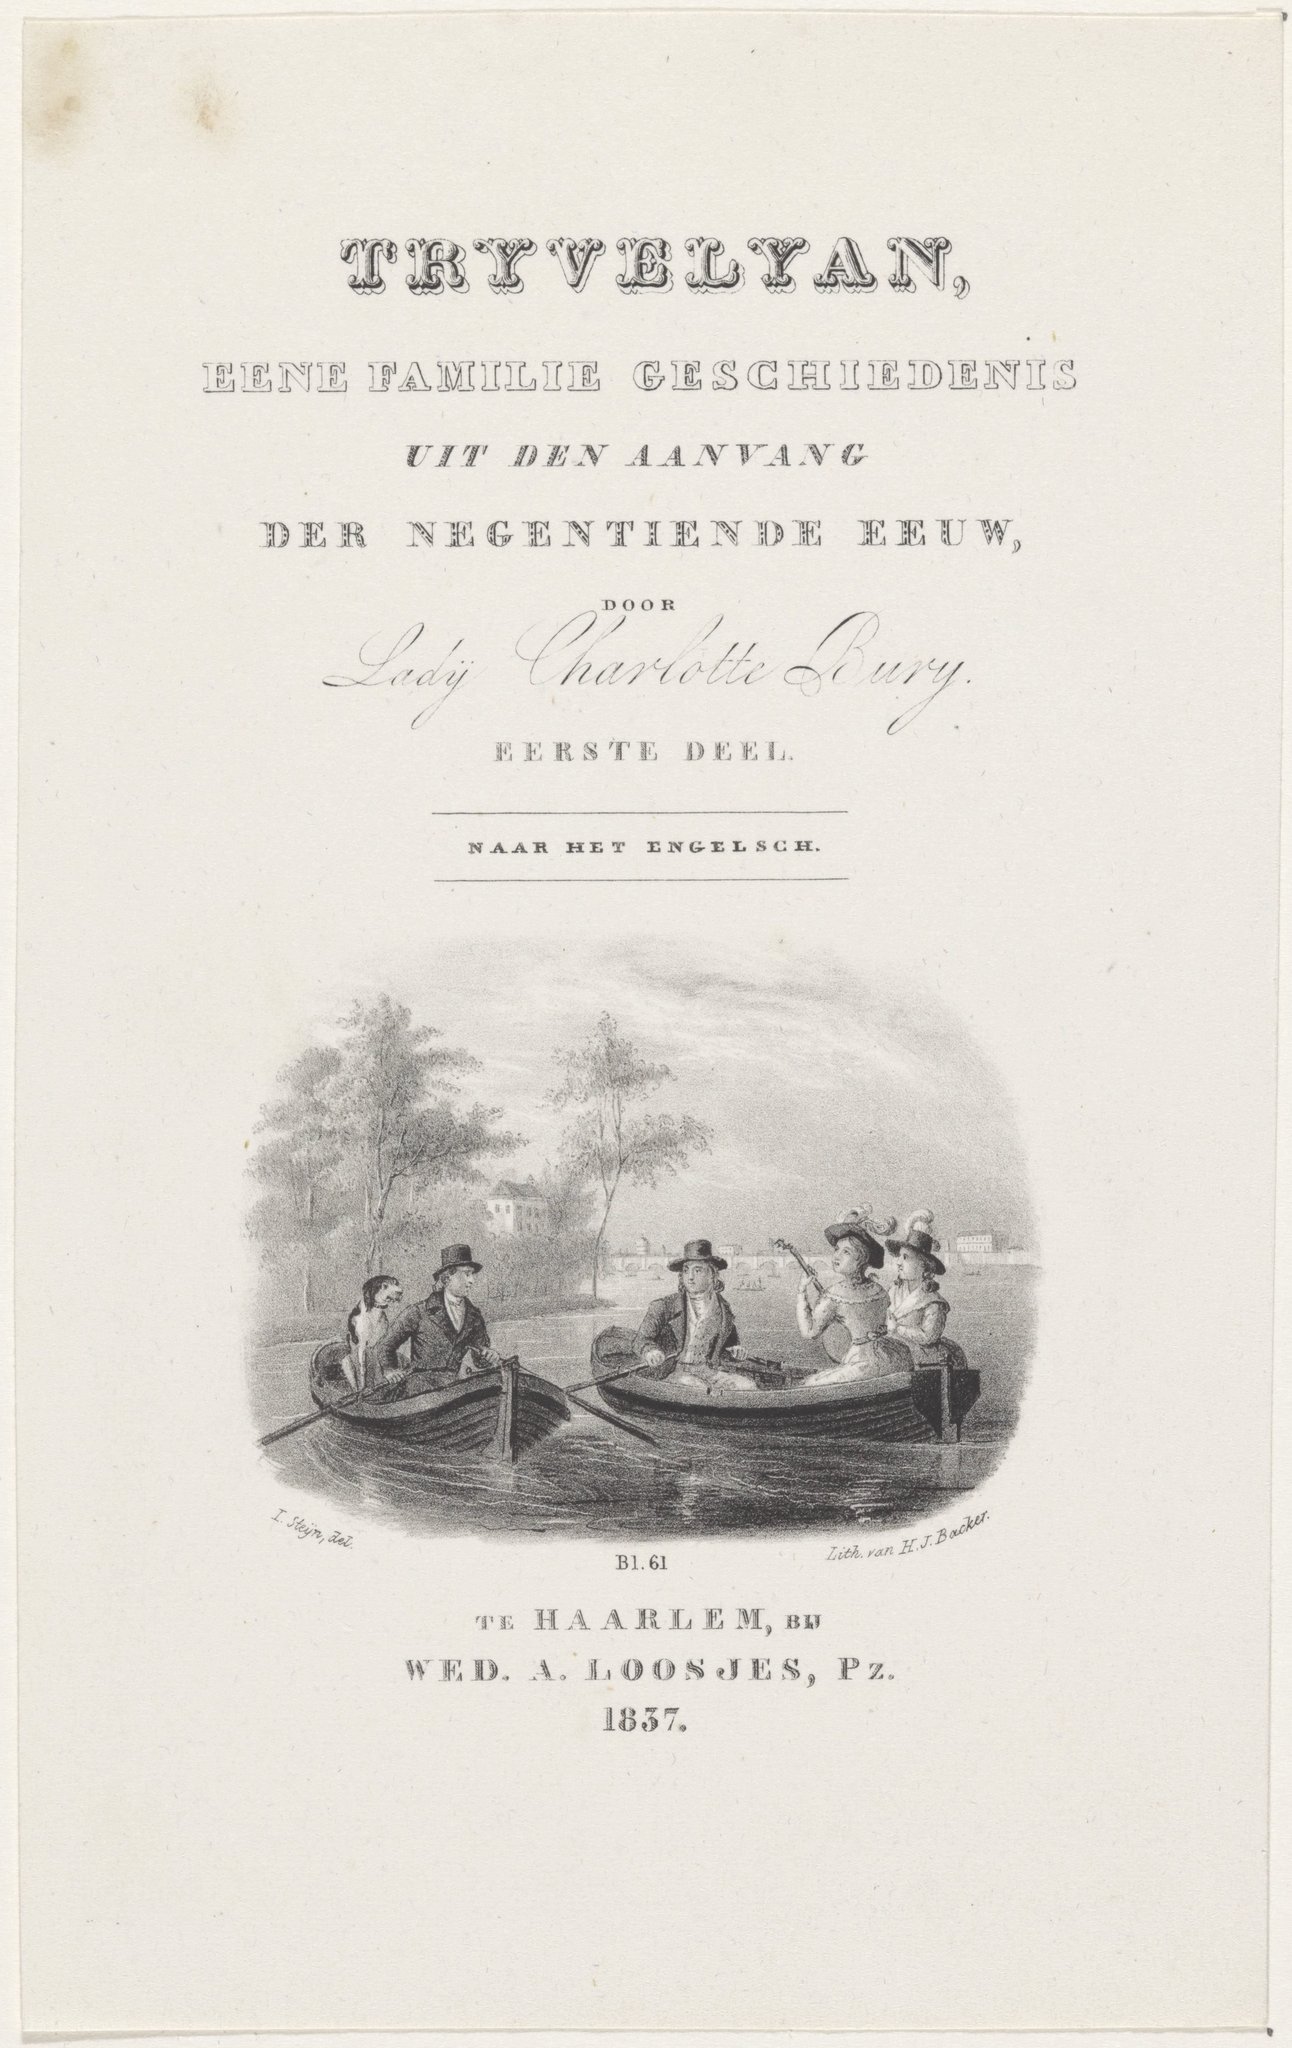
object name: titelblad, titelpagina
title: Ontmoeting tussen twee boten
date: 1837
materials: paper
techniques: lithograph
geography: amsterdam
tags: rowing facing backward, pulling, dog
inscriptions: collector's mark: Lugt 2228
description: Twee roeiboten met figuren circelen om elkaar heen op het water. In een boot zit een man met een hond. In de andere boot een man met twee vrouwen. Een vrouw bespeeld een luit of gitaar.